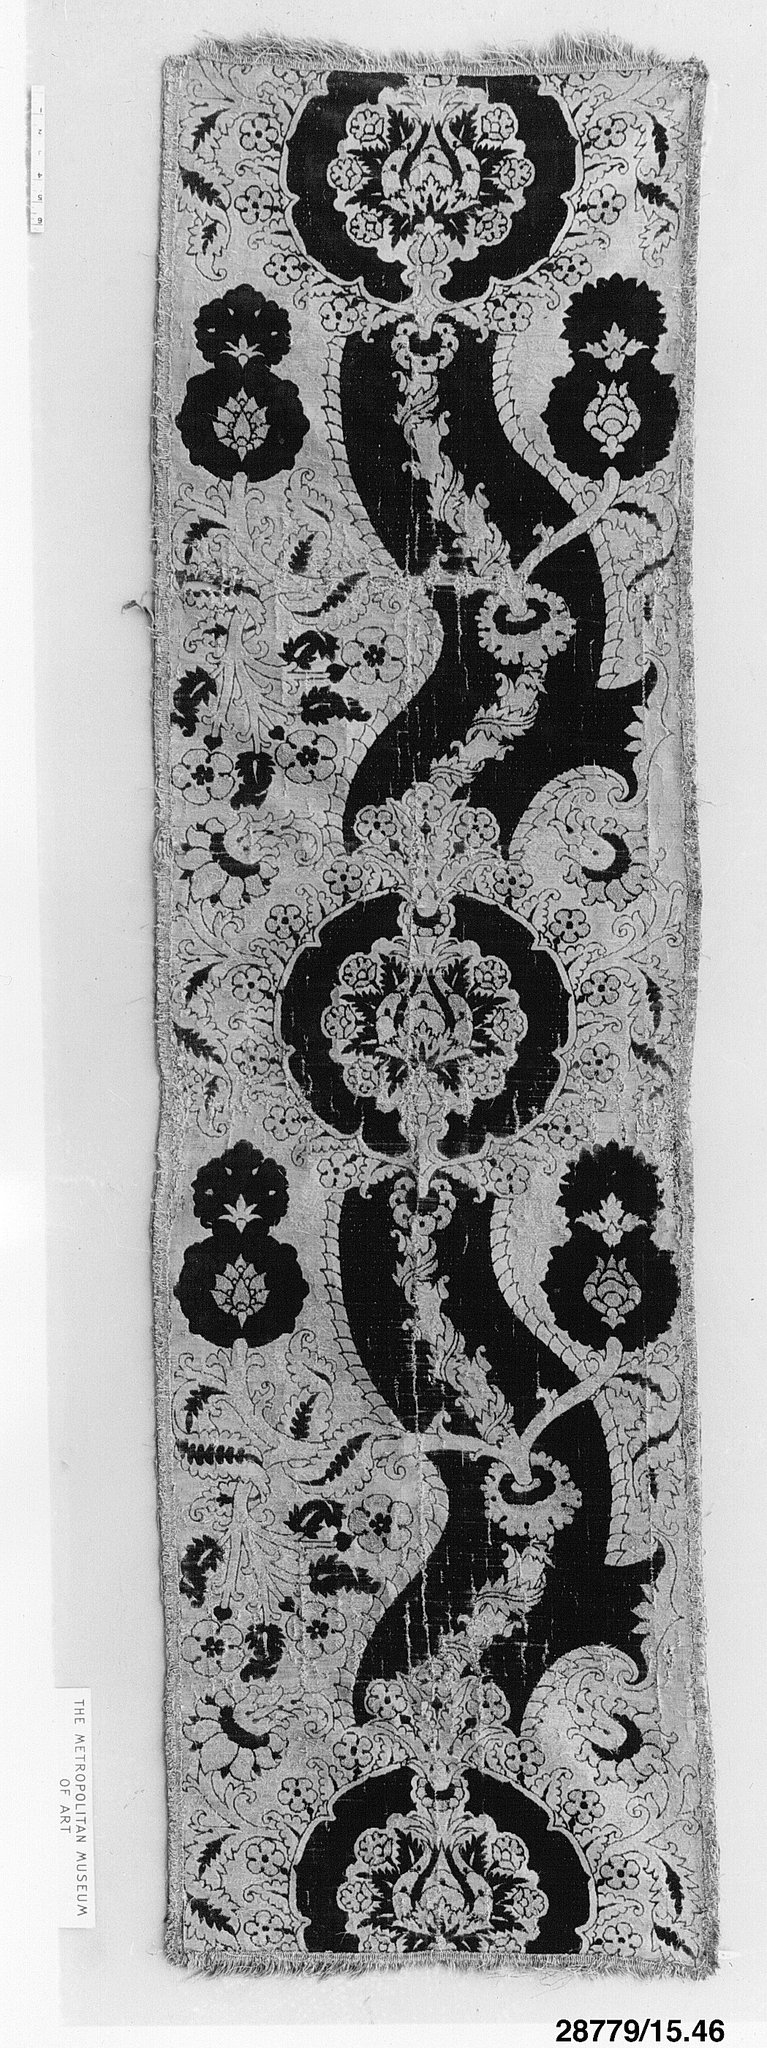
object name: piece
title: Length of velvet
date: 1467-1500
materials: metal thread, silk